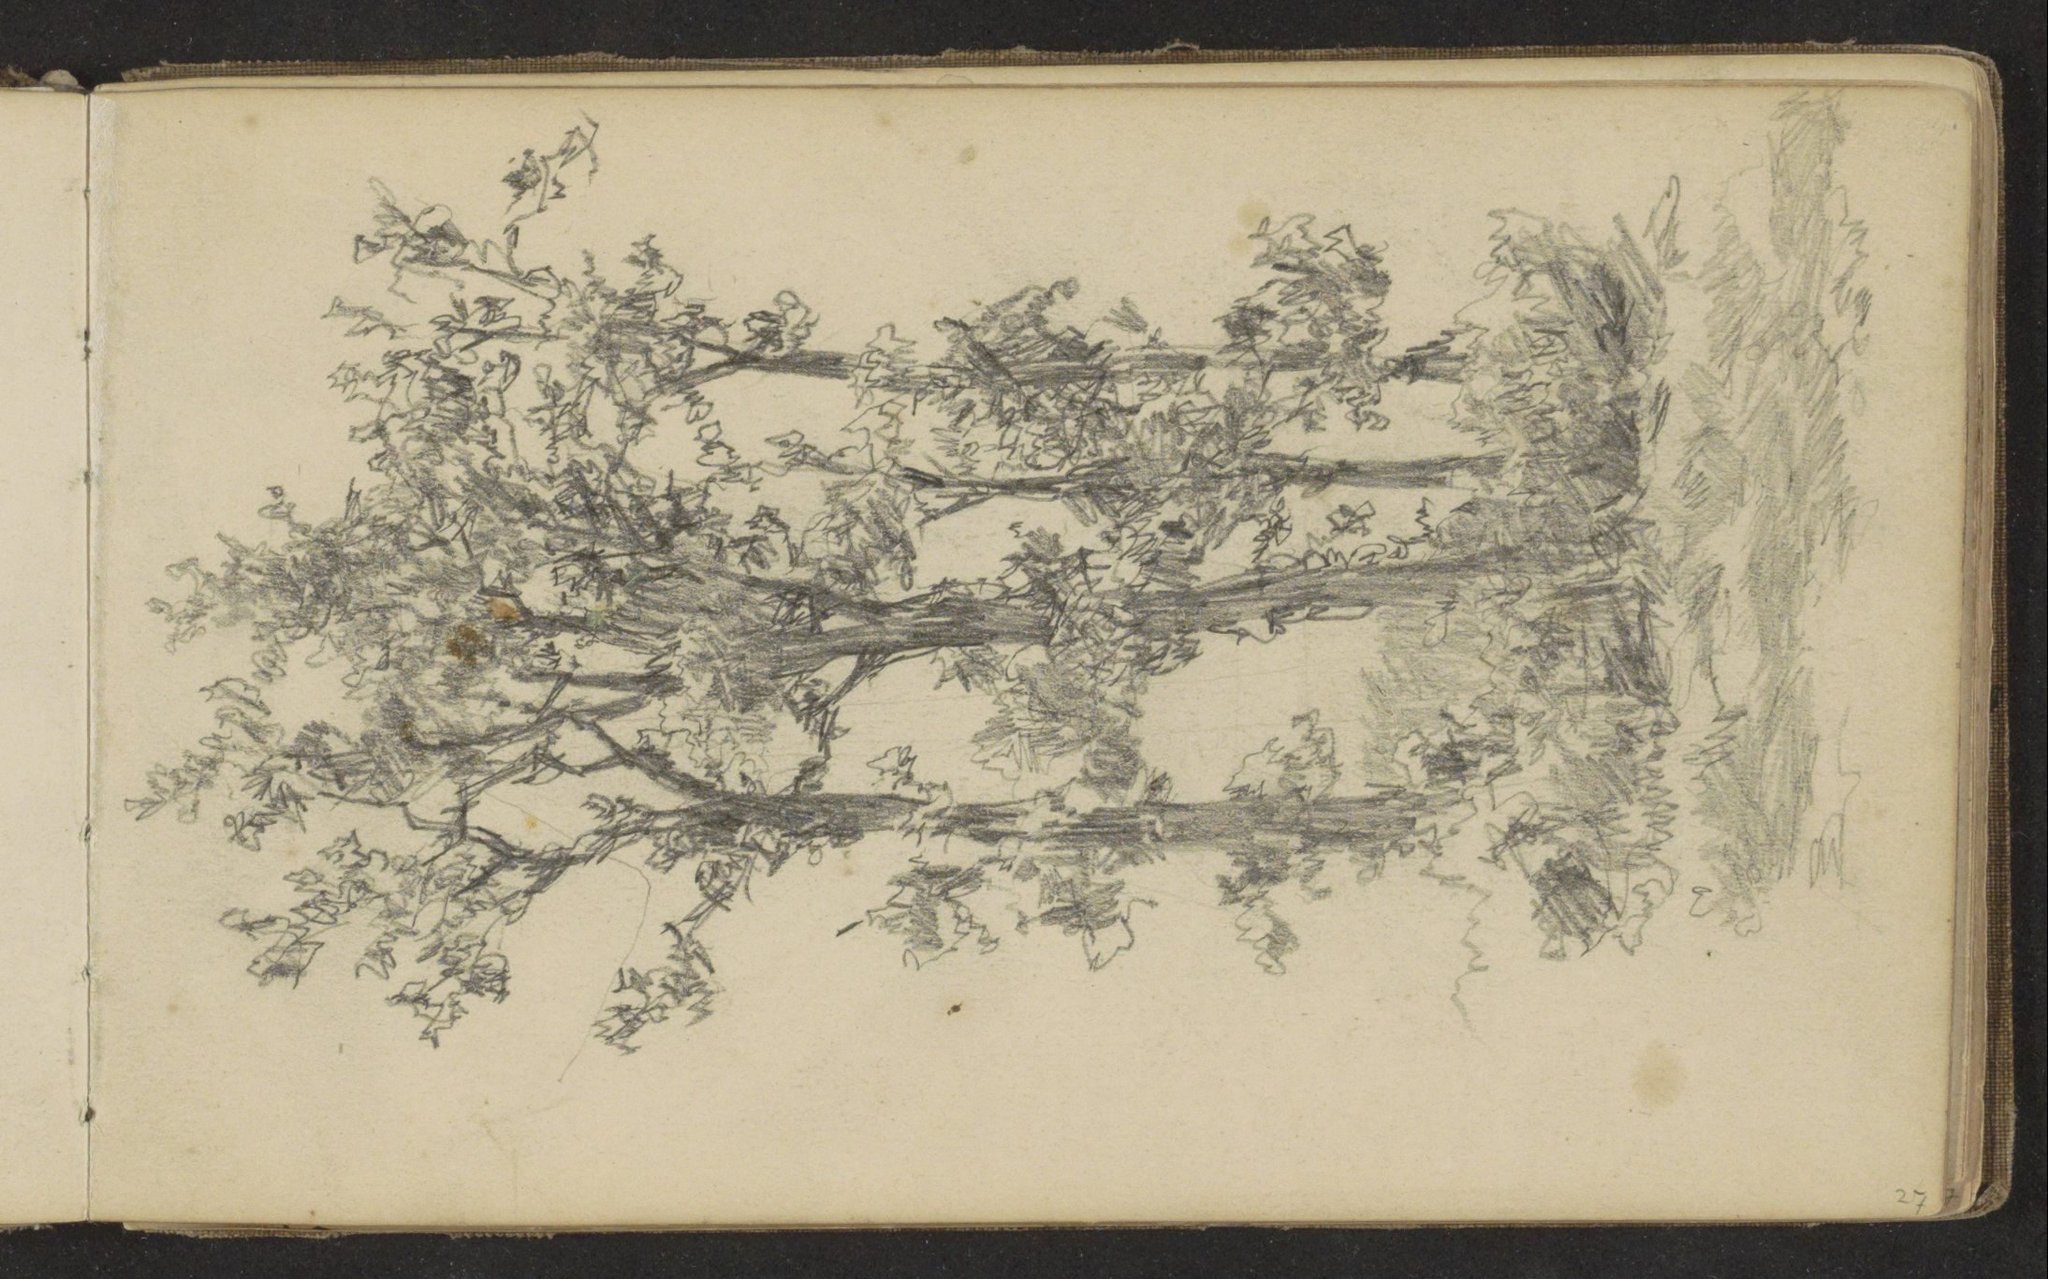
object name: sketchbook leaf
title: Vier bomen op een rij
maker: johan hendrik weissenbruch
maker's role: draughtsman, painter, print maker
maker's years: 1824-1903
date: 1834-1903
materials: paper, pencil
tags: trees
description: Blad 27 recto uit een schetsboek met 43 bladen.